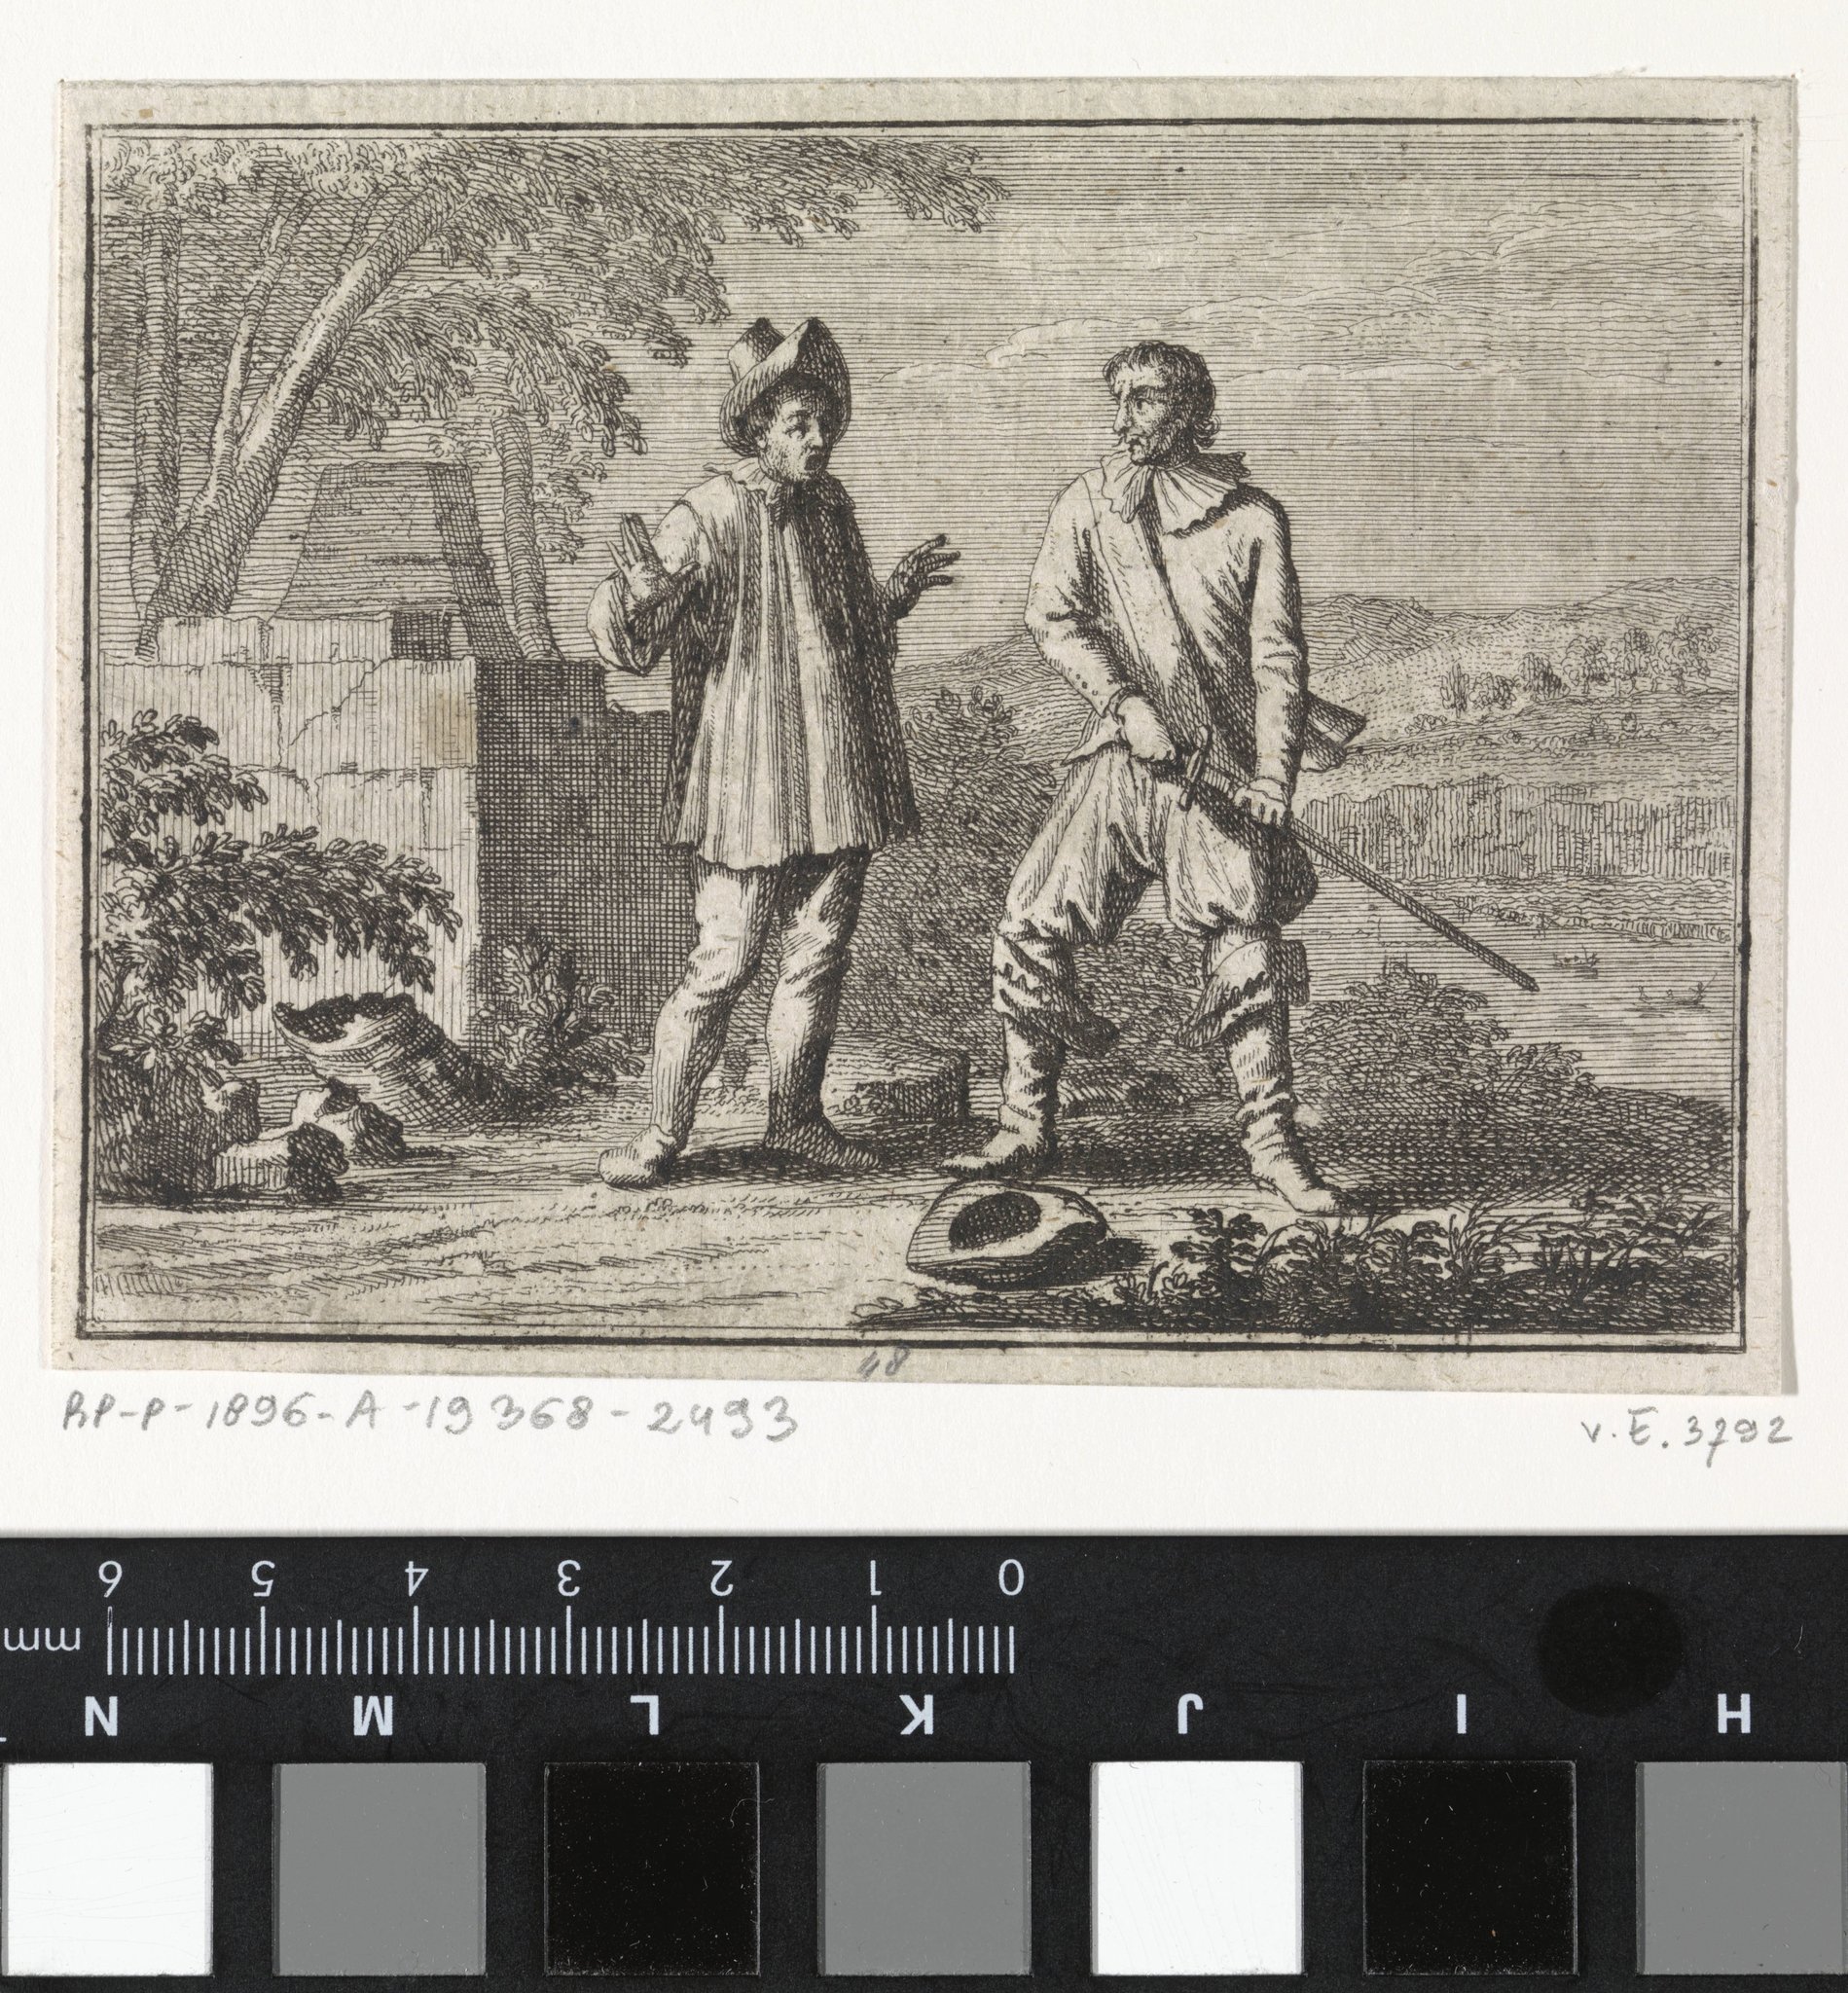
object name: print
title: Edelman trekt zijn zwaard tegen een boer die hem belasterde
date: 1710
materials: paper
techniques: etching, letterpress printing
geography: nuremberg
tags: hacking and thrusting weapons: sword, mocking, insulting; teasing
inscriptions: collector's mark: Lugt 2228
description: Illustratie uit: Abraham a Sancta Clara. Heilsames Gemisch Gemasch, das ist: Allerley seltsame und verwunderliche Geschichten (...). Neurenberg: Christoph Weigel, 1710, p. 488.